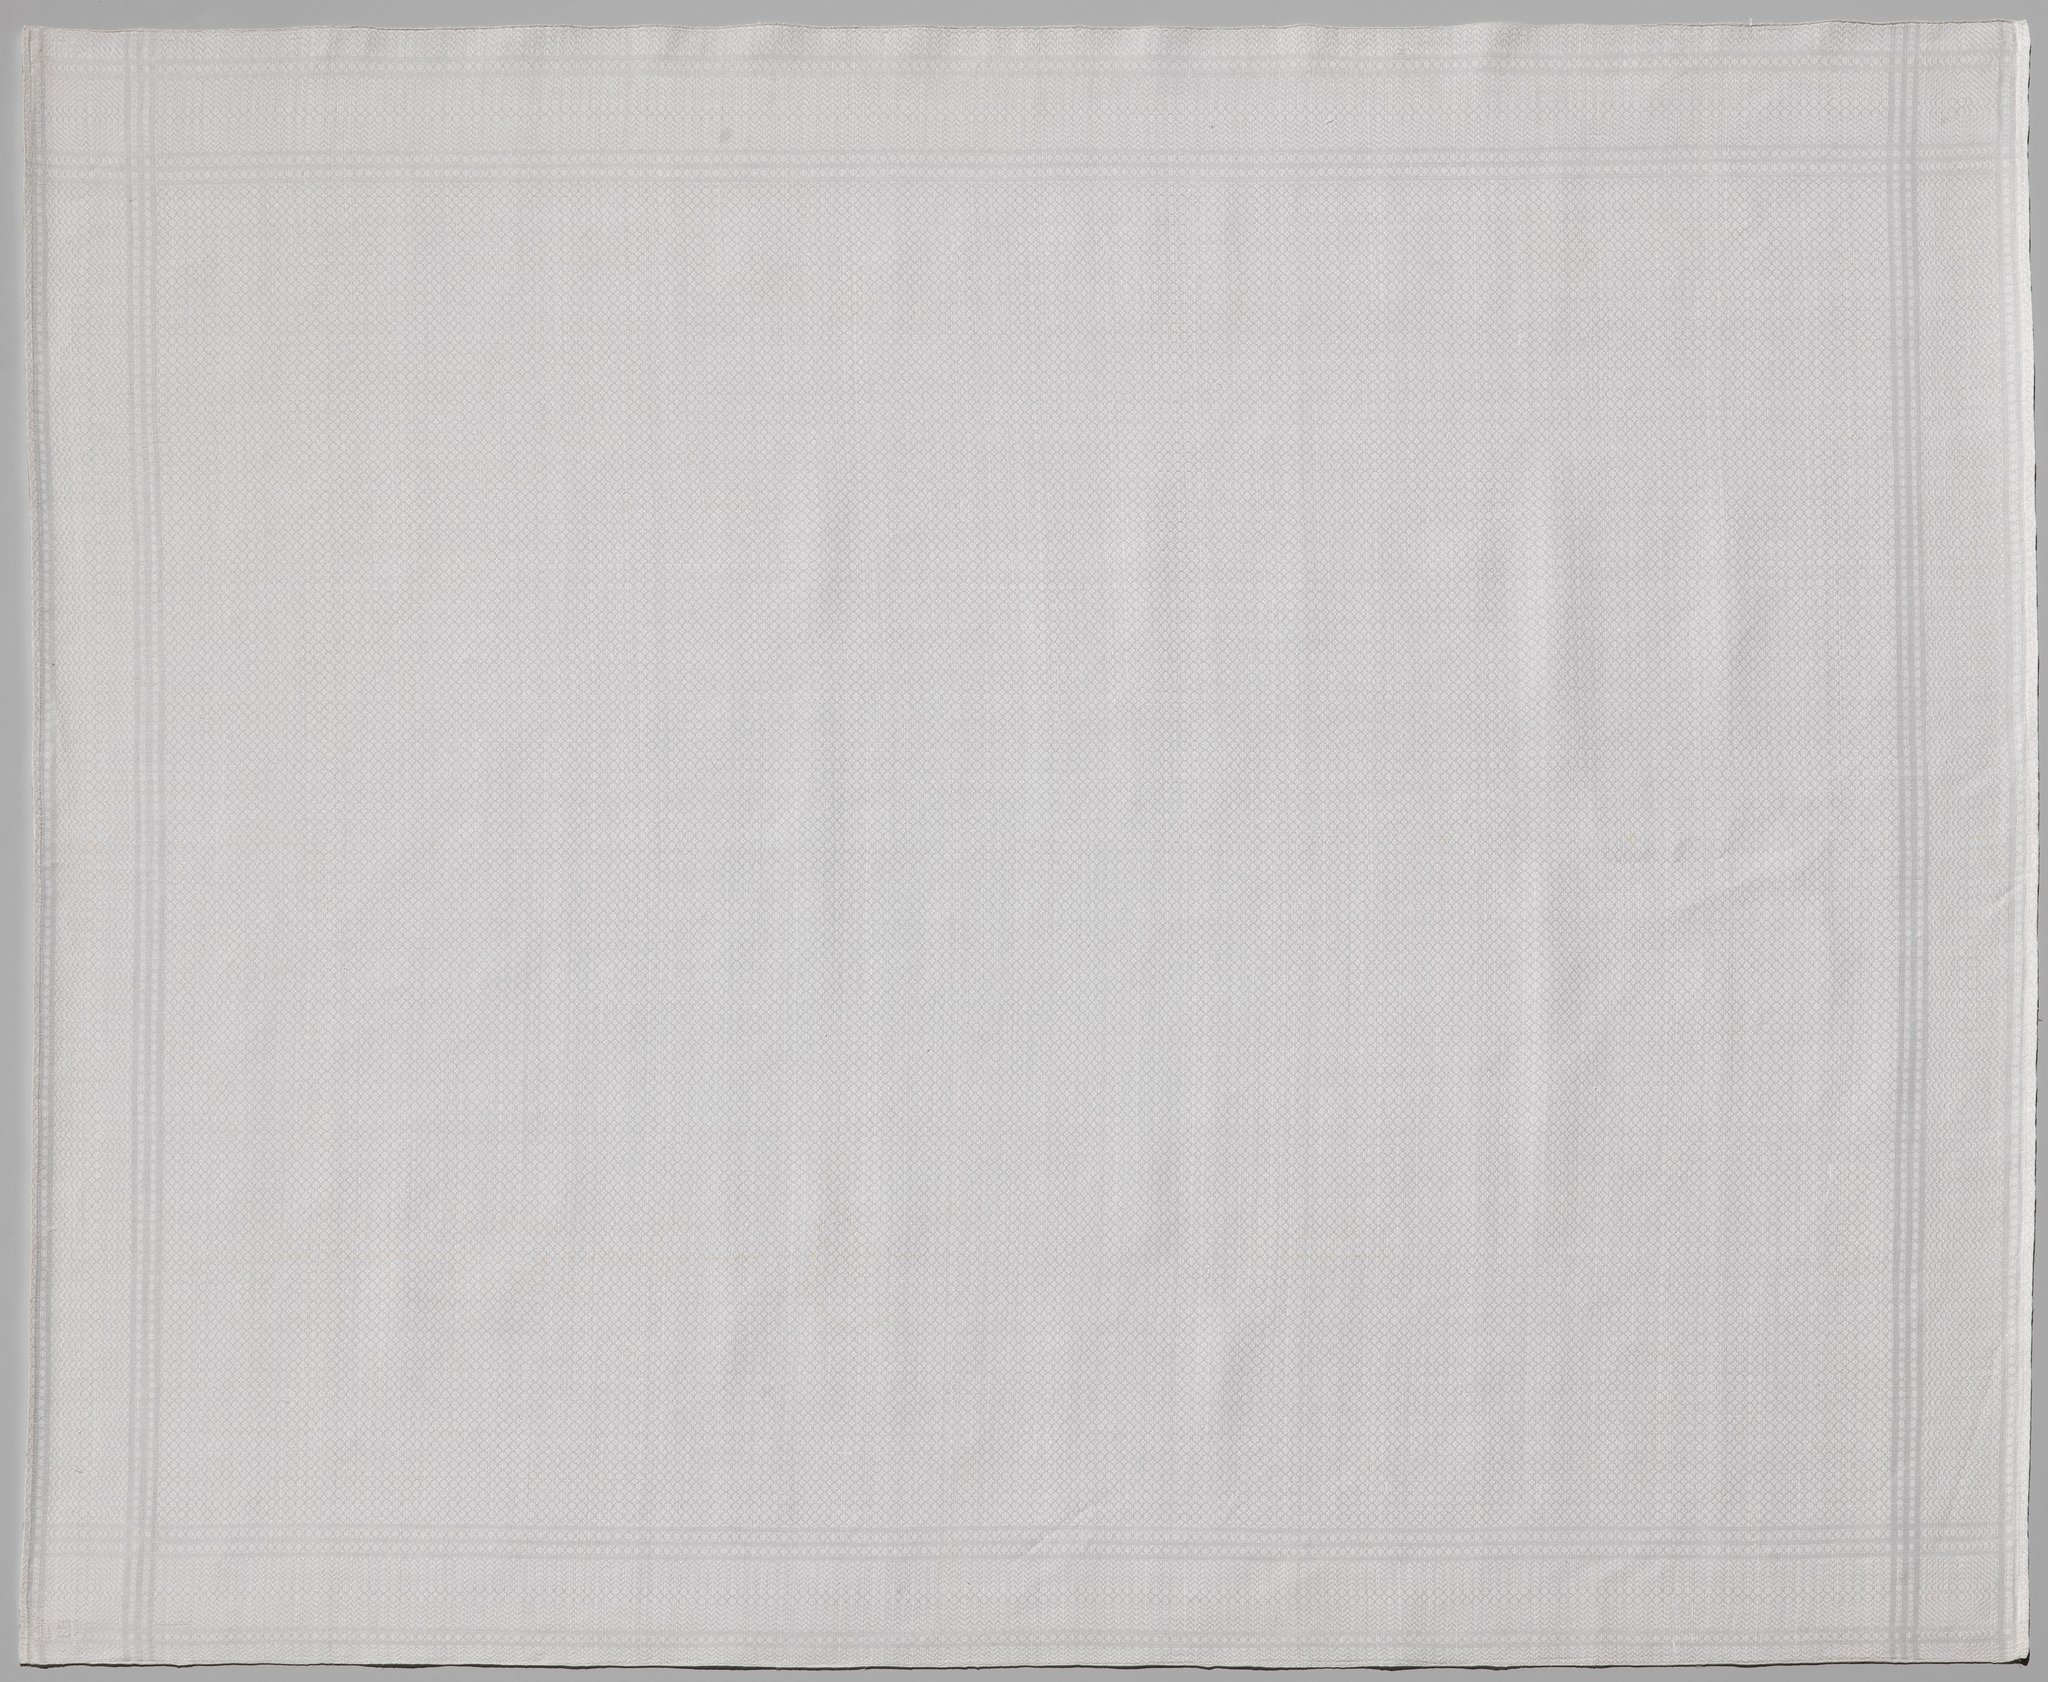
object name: napkin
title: Servet van linnendamast met de overwinningen op de Turken door Eugenius van Savoye onder Karel VI van Oostenrijk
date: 1717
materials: linen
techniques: damask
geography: flanders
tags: paris, eugenius van savoye, vienna, charles vi (holy roman emperor)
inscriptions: : ‘T C 38’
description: Wit linnendamasten servet met de overwinningen op de Turken door Eugenius van Savoye onder Karel VI van Oostenrijk. Ingeweven: BELGRADE en TVRCA PRECATVR VITAM. Gemerkt T C 38.